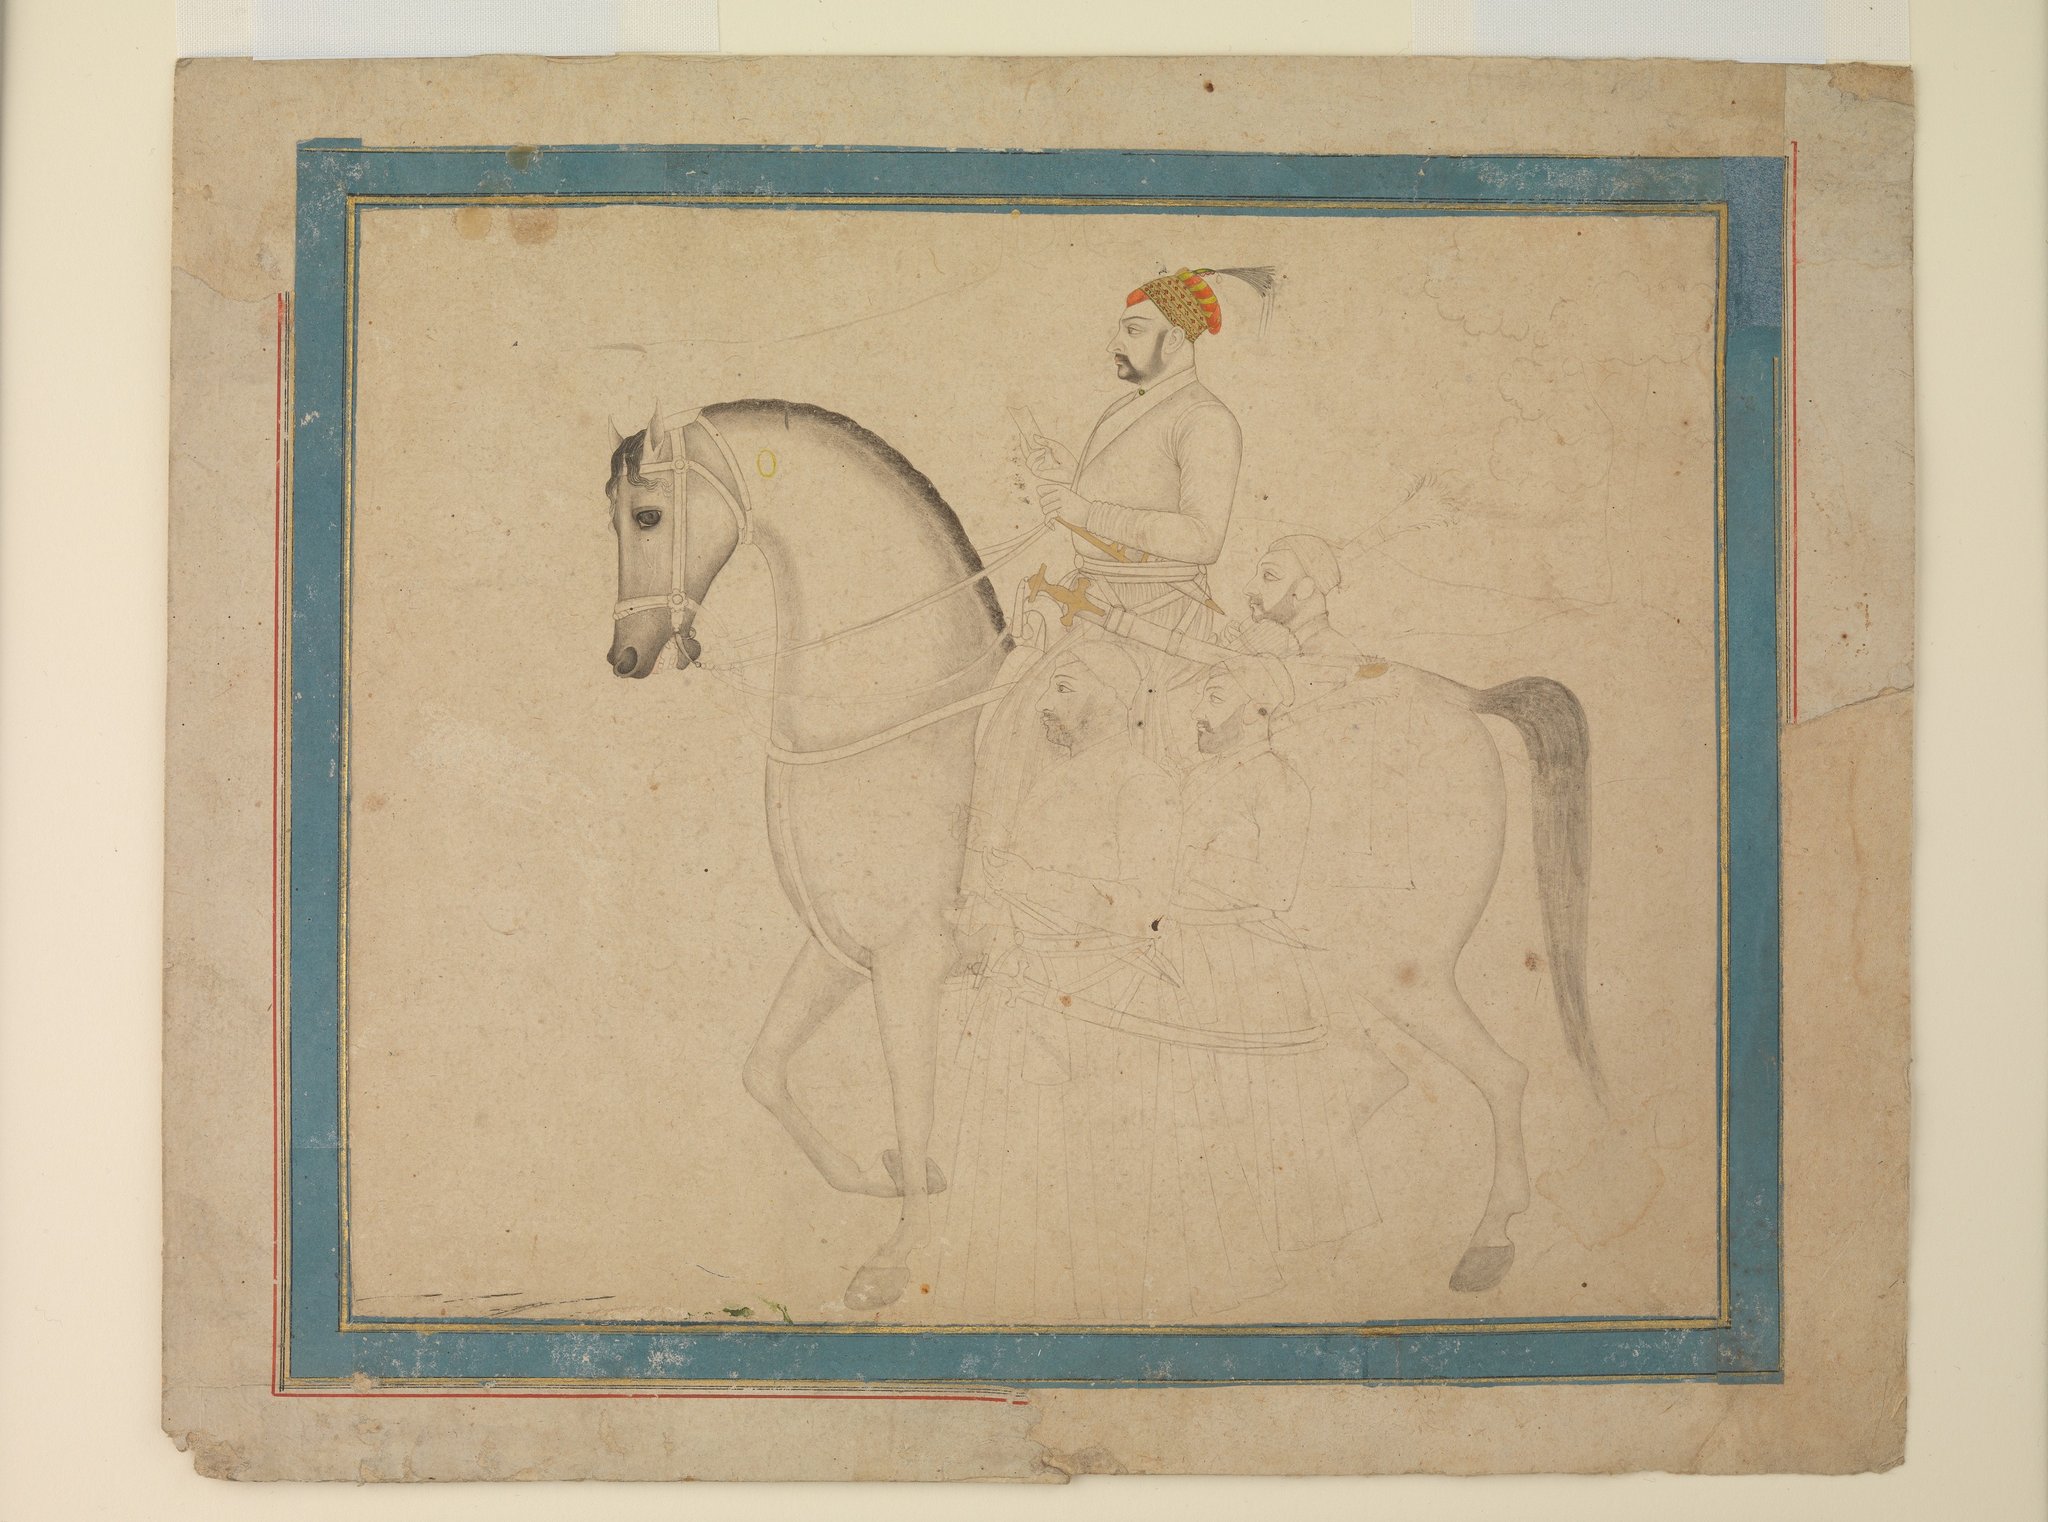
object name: illustrated single work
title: Nawab Muzaffar 'Ali Khan on Horseback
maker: rai kalyan das (chitarman ii)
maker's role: artist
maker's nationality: indian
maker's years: 1690-1785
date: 1730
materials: gold, ink, paper, watercolor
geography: india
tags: men,horses